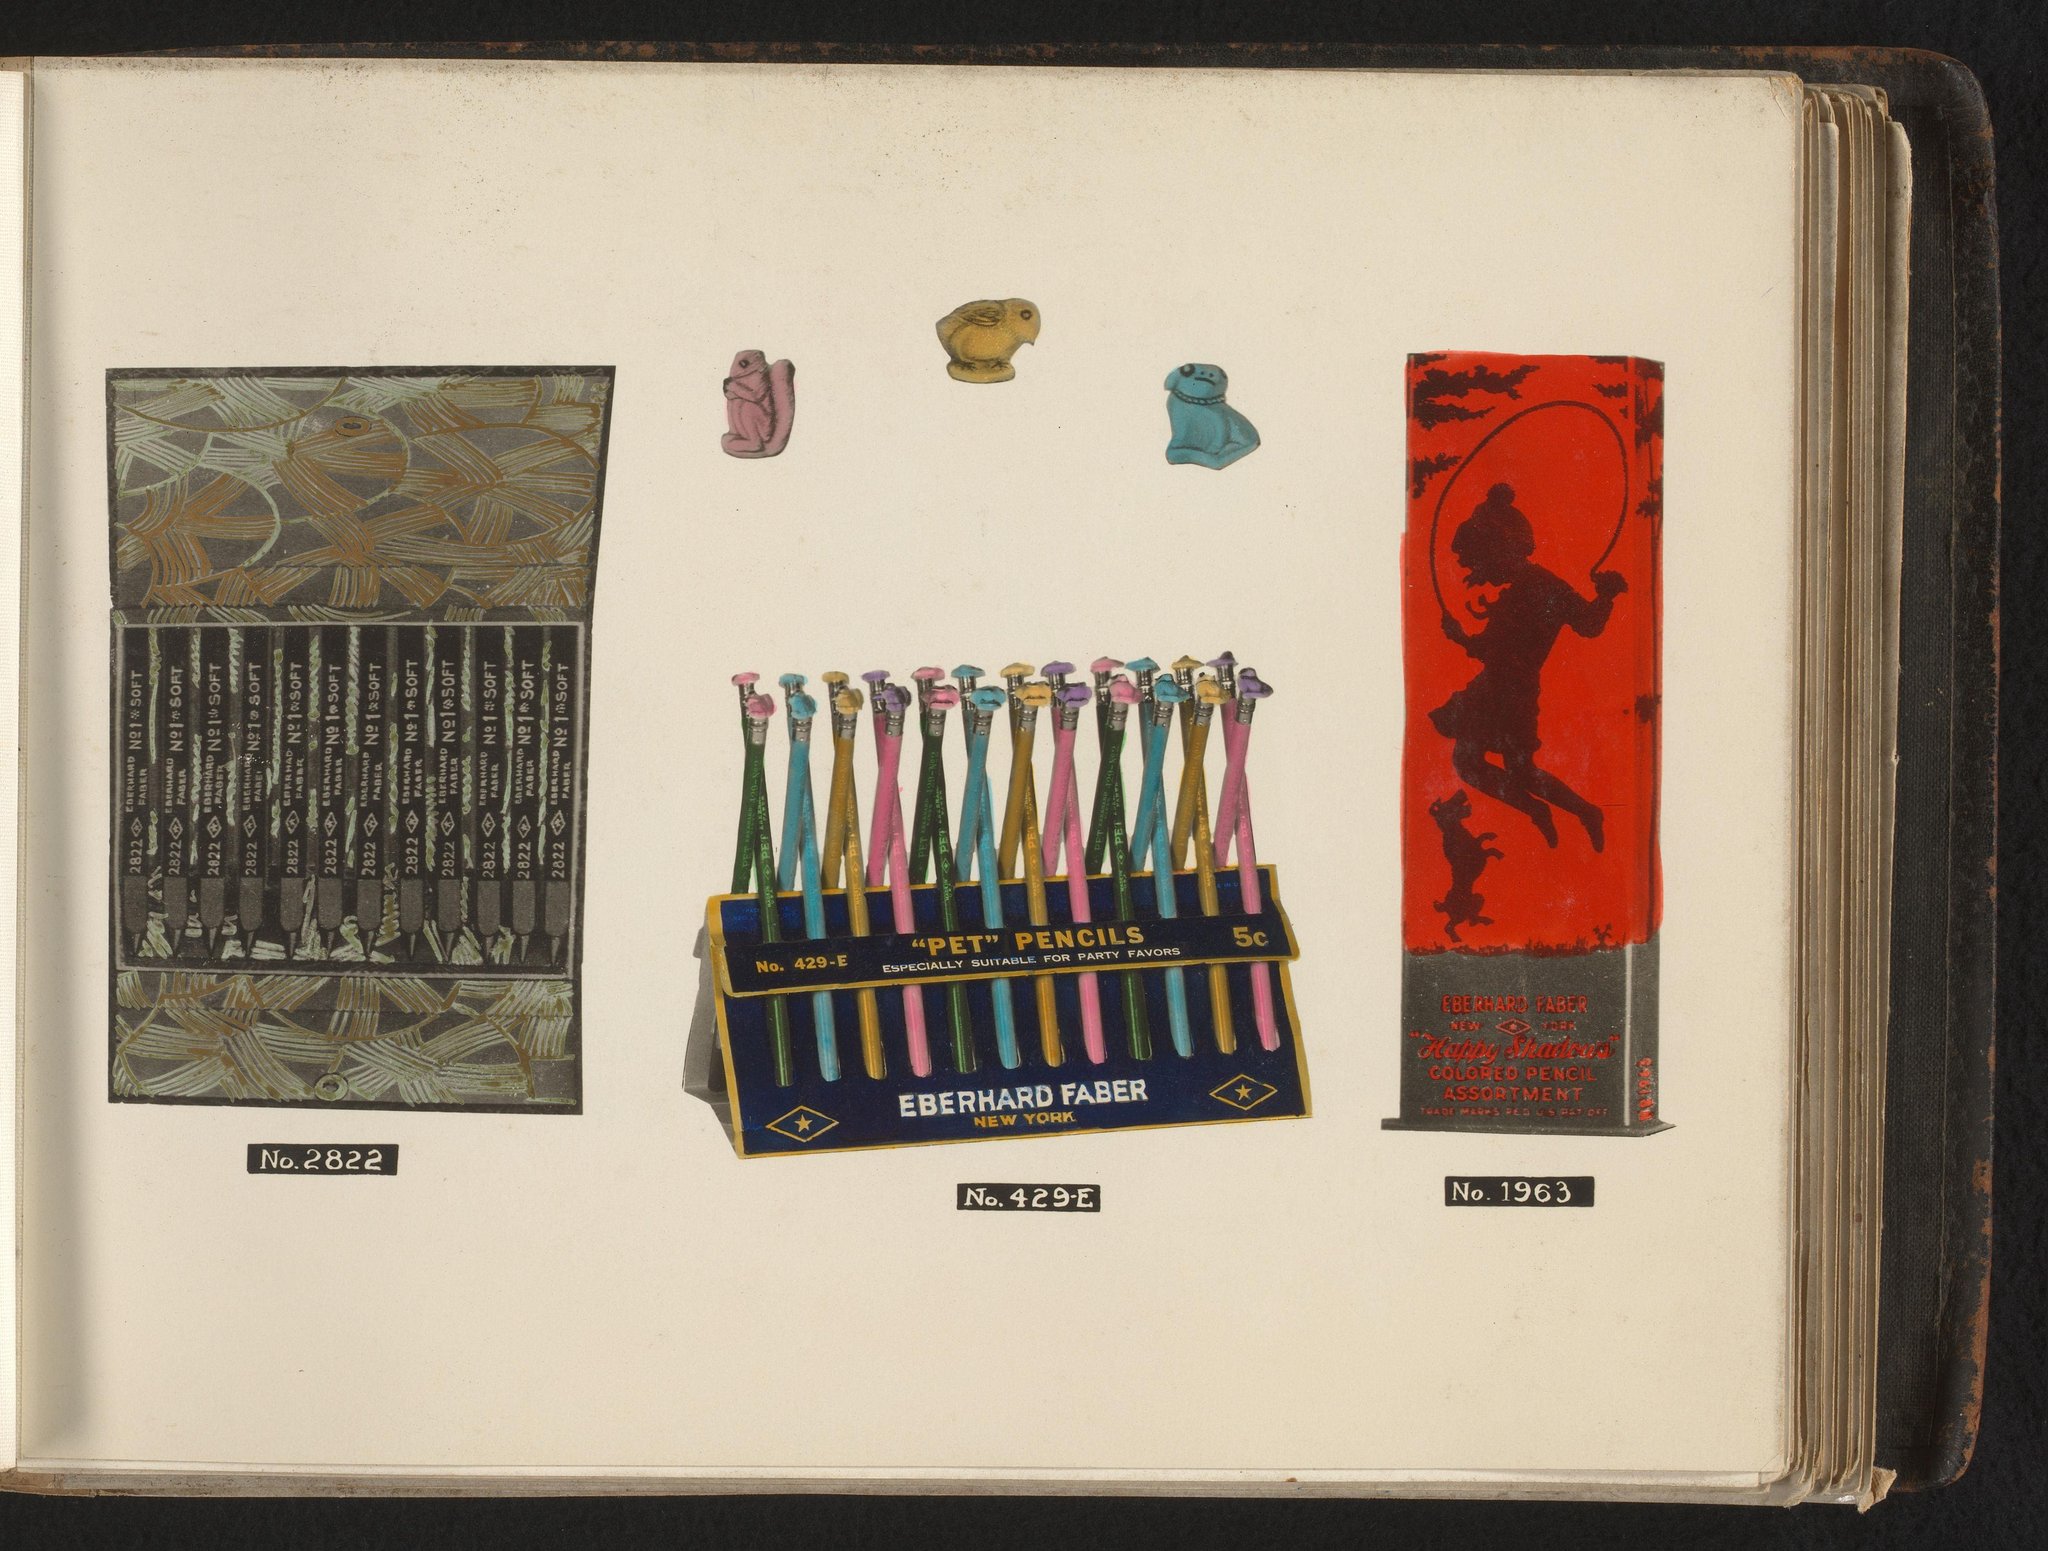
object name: photograph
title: Sets met potloden van Eberhard Faber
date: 1915-1935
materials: paper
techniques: gelatin silver print, hand coloring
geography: springfield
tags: pencil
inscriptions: stamp: ‘Paramount/ Commercial Studios/ 145 Chestnut St./ Springfield - Mass.’